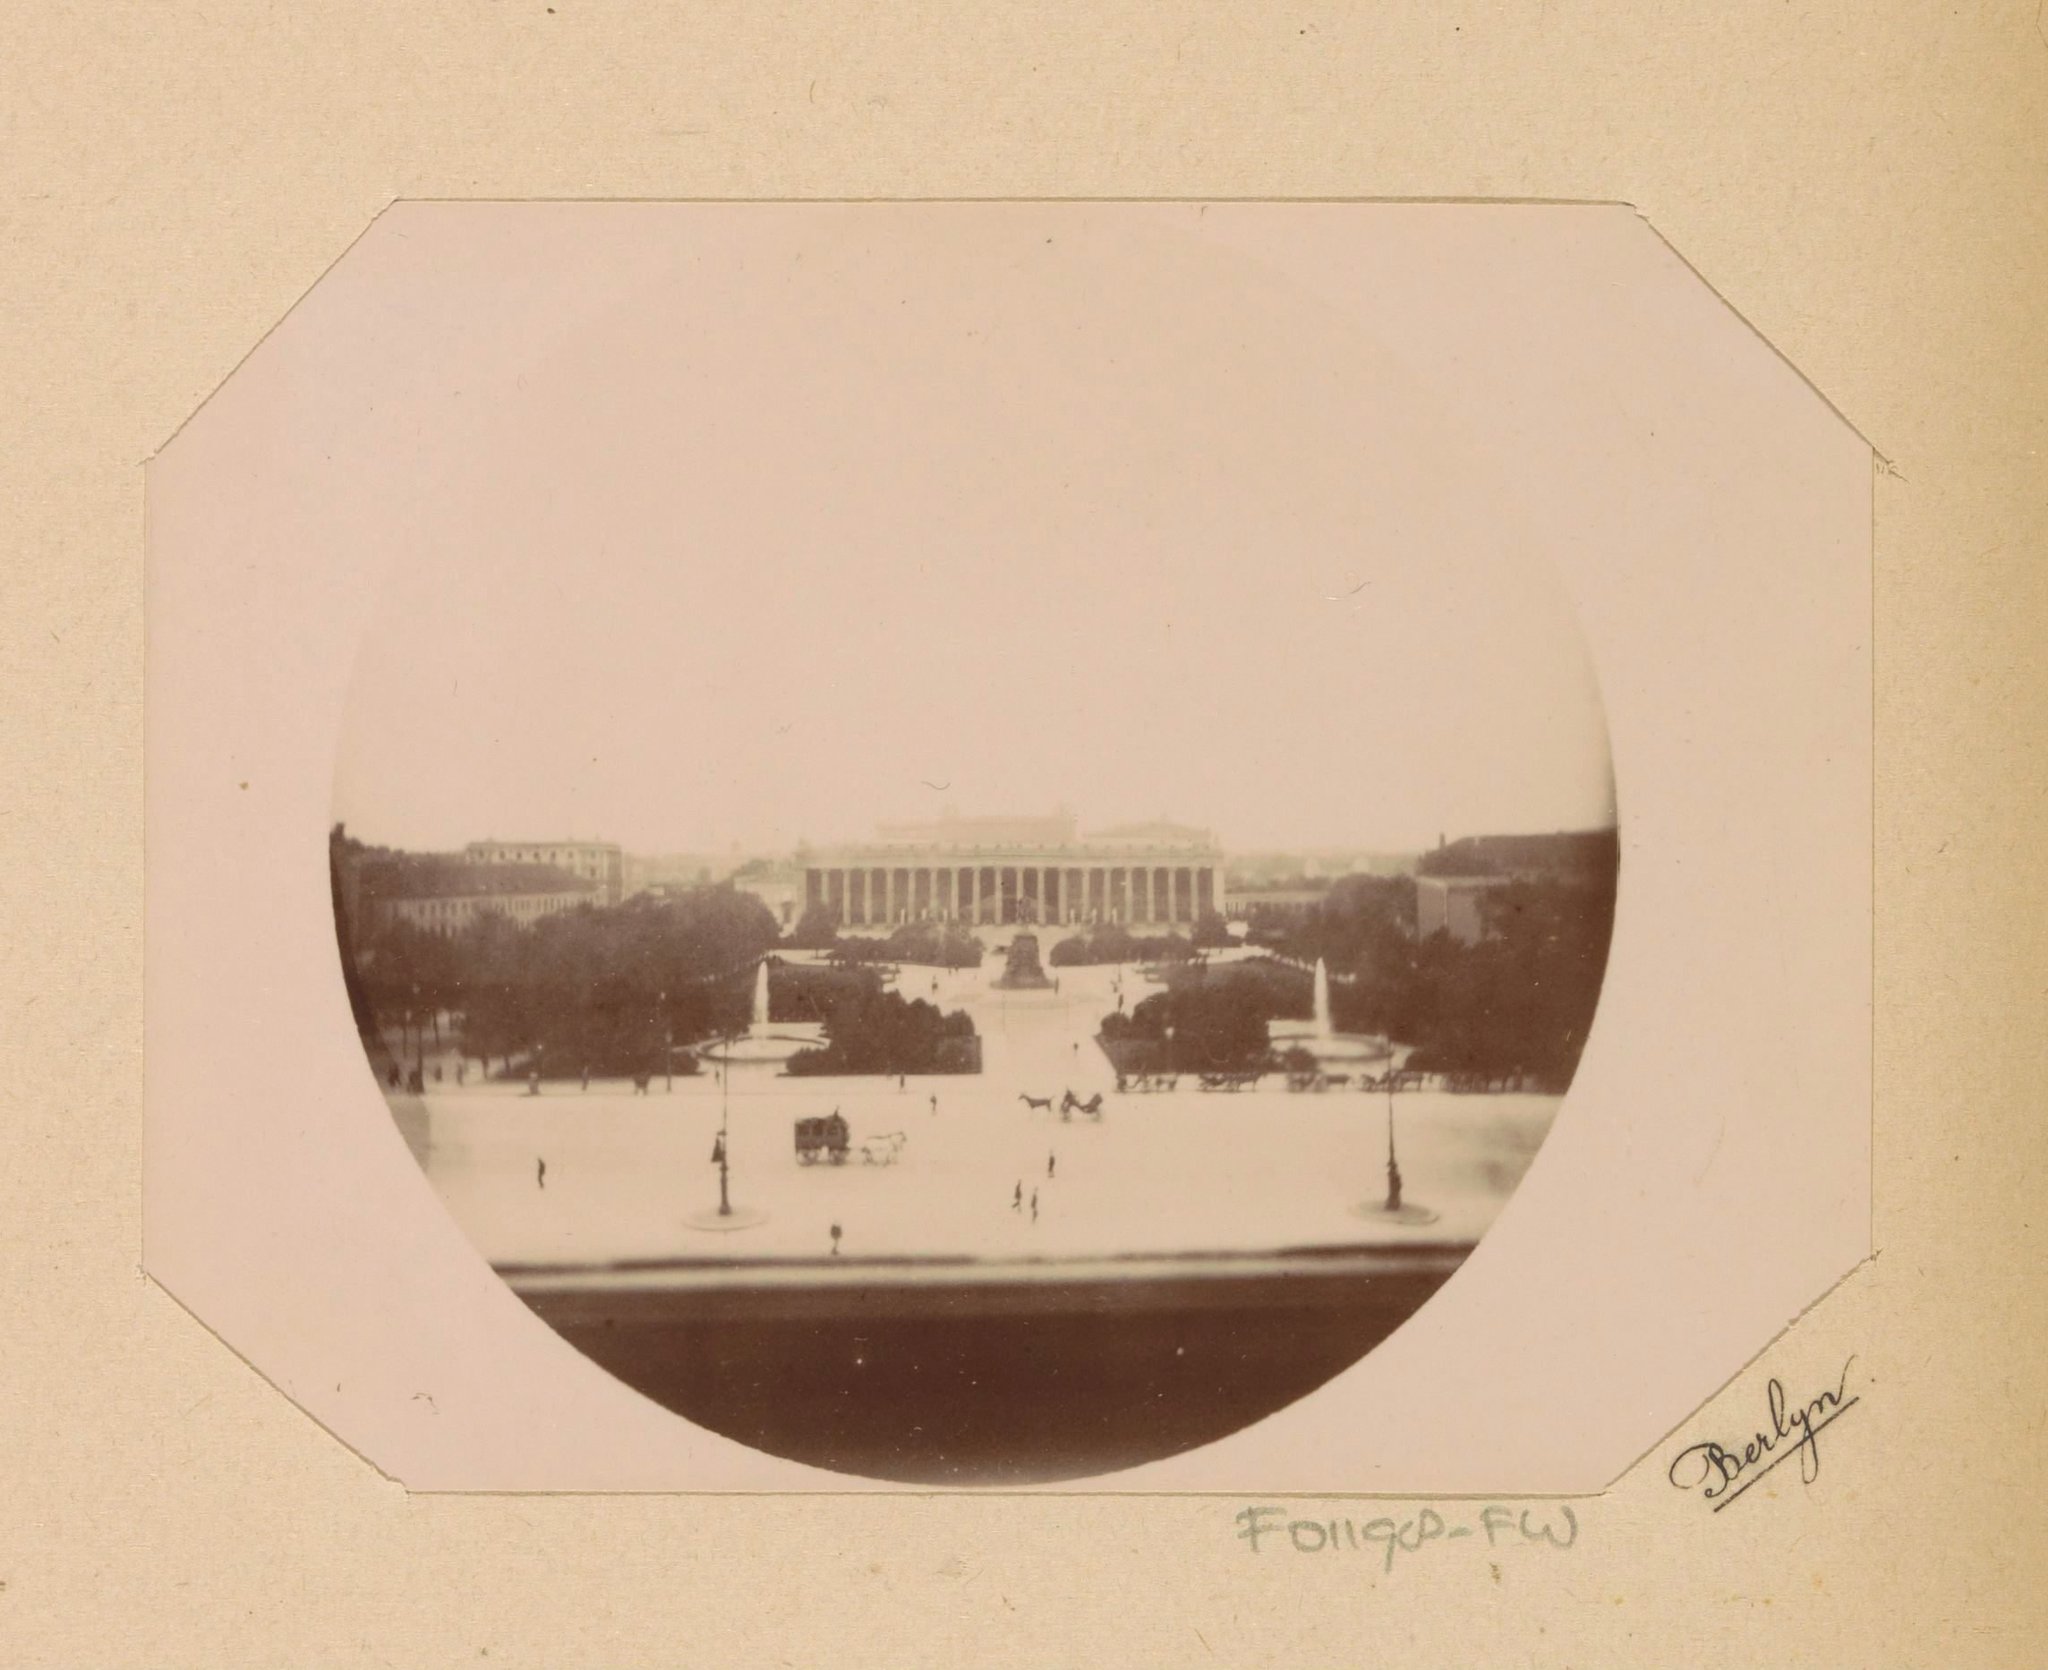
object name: album leaf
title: Gezicht op het Altes Museum in Berlijn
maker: willem frederik piek jr.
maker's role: fotograaf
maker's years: 1874-1954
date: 1889-1893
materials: paper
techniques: gelatin silver print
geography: berlin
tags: permanent exhibition, museum